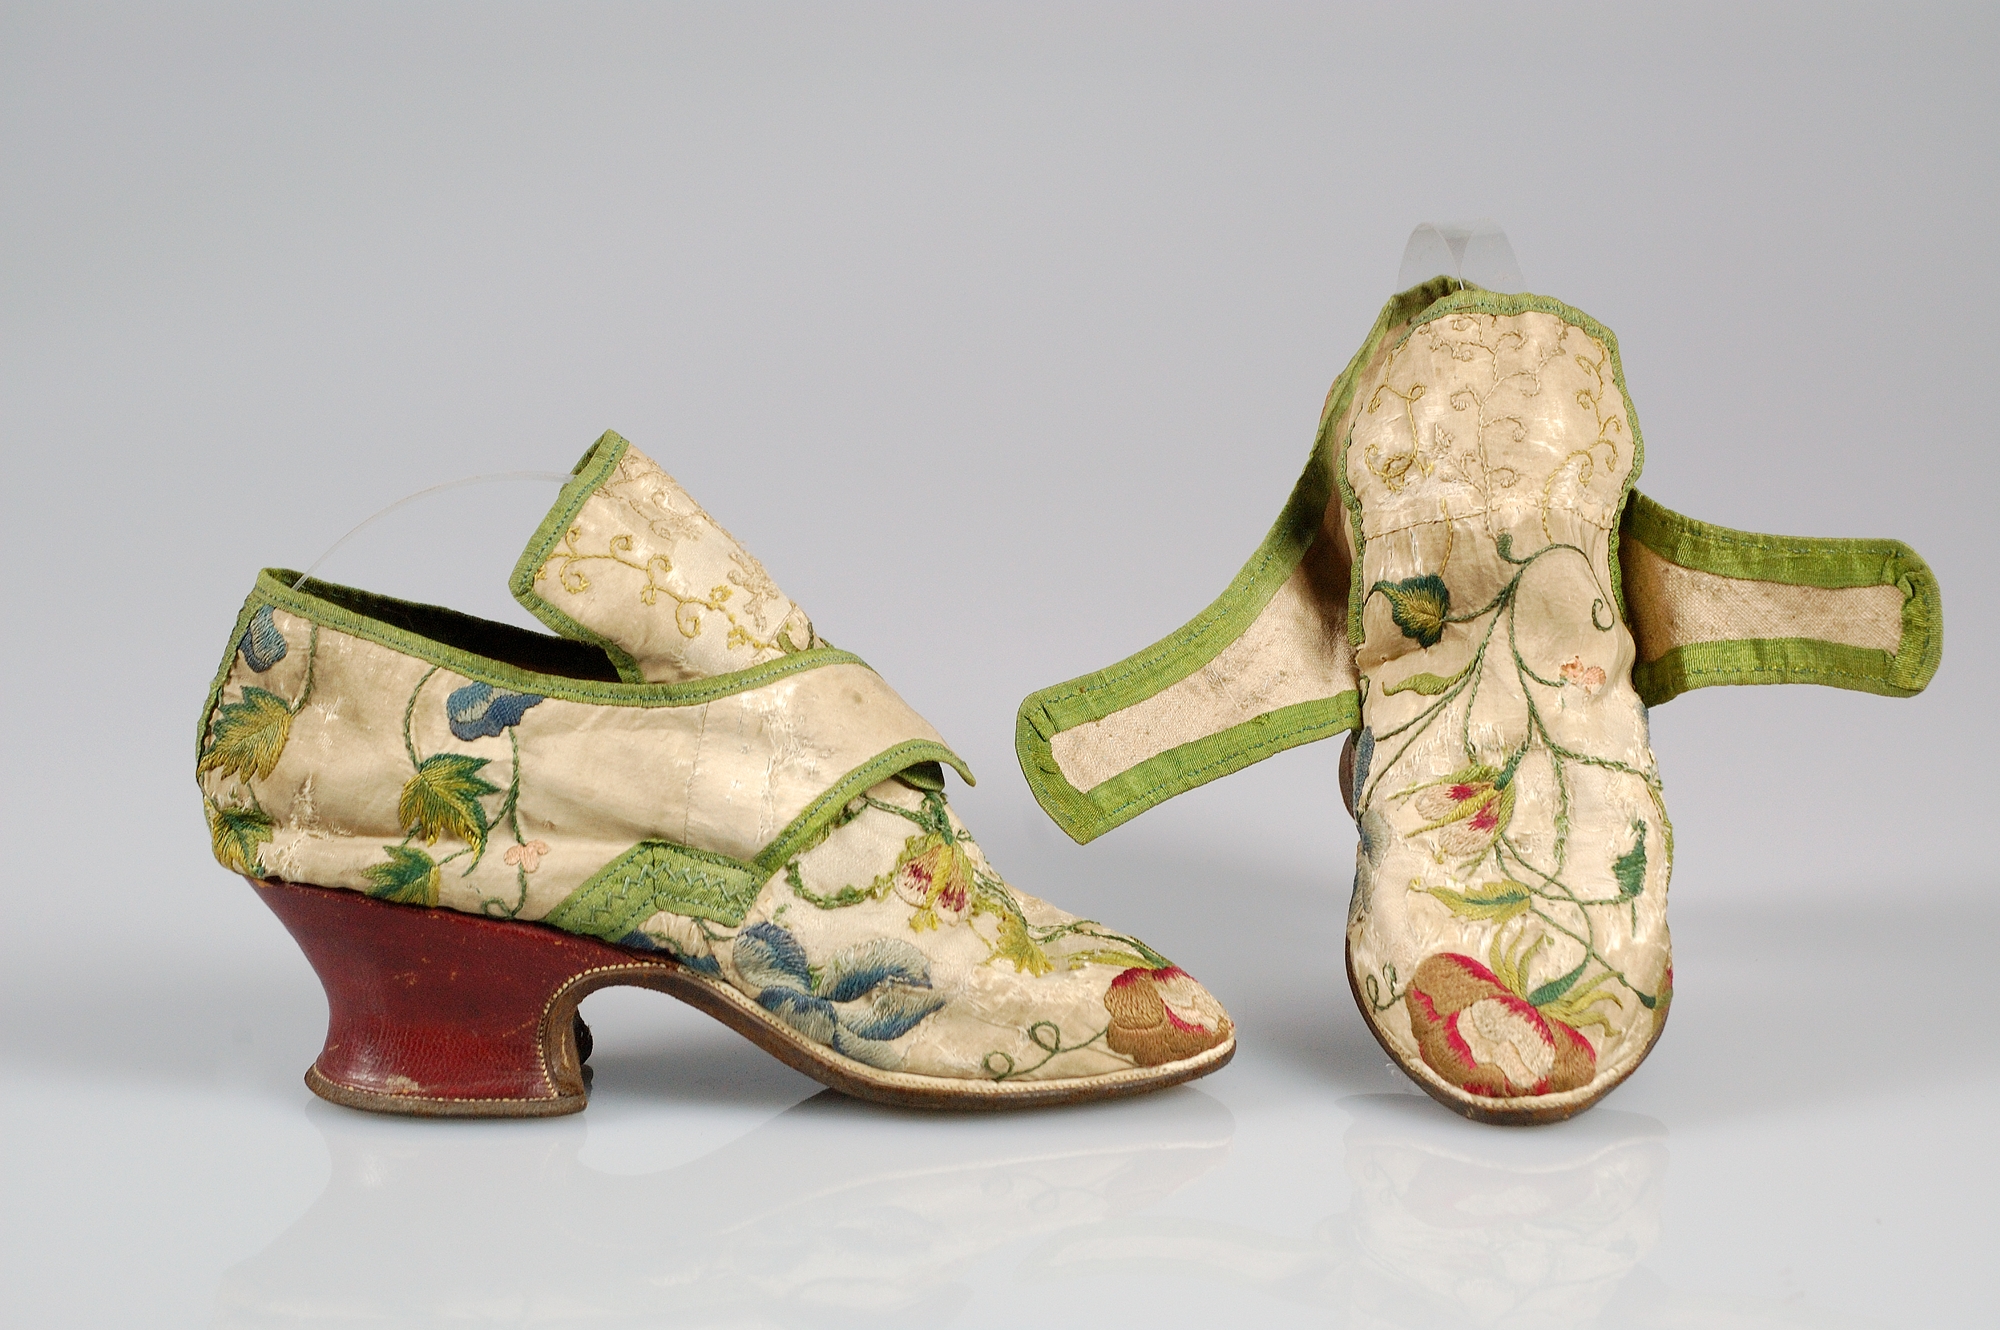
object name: shoe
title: Shoes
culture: british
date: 1740-1759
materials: leather, silk